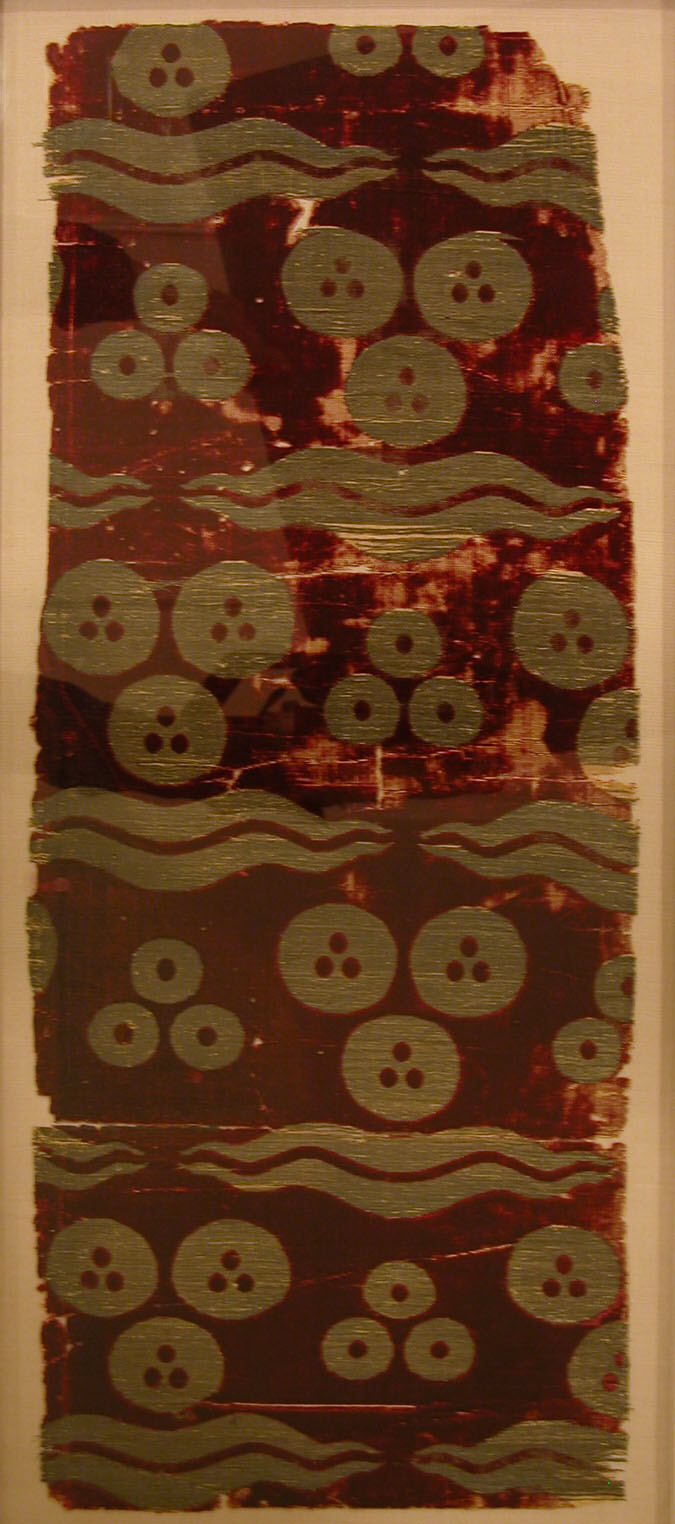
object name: textile fragment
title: Silk Velvet Fragment with Tiger-Stripe and 'Cintamani' Design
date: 1501-1600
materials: metal thread, silk, velvet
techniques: brocade, cutting, voiding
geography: turkey